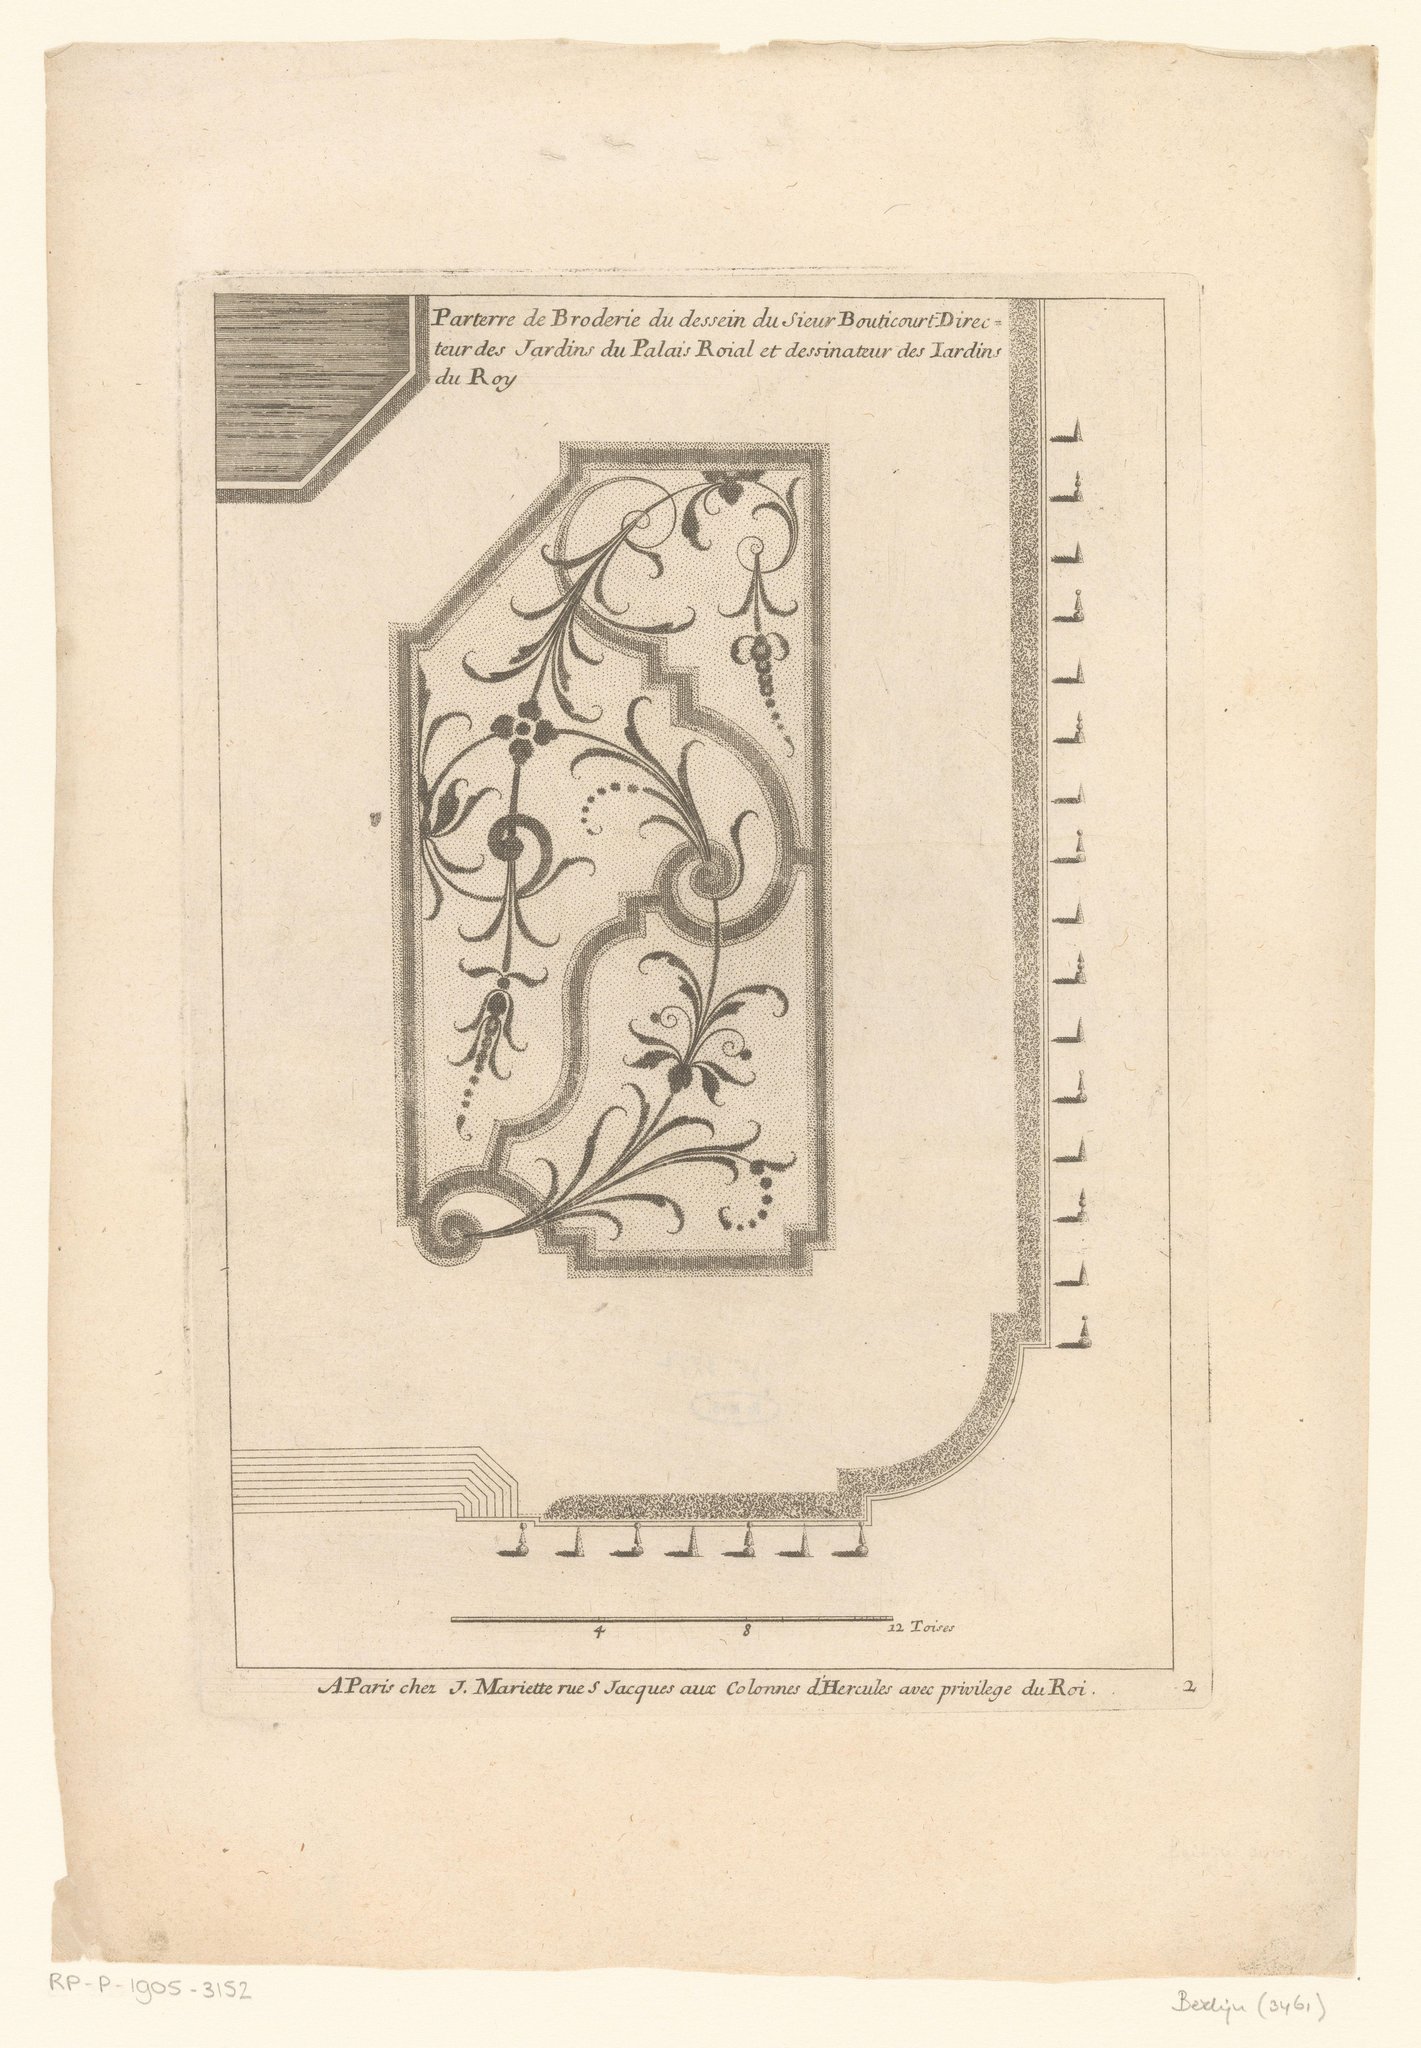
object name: ornament print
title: Parterre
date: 1691-1742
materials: paper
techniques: etching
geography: paris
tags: plan, map of garden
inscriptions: collector's mark: Lugt 2228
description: Een parterre en in de linkerbovenhoek een deel van een waterpartij, mogelijk een vijver of fonteinbassin.